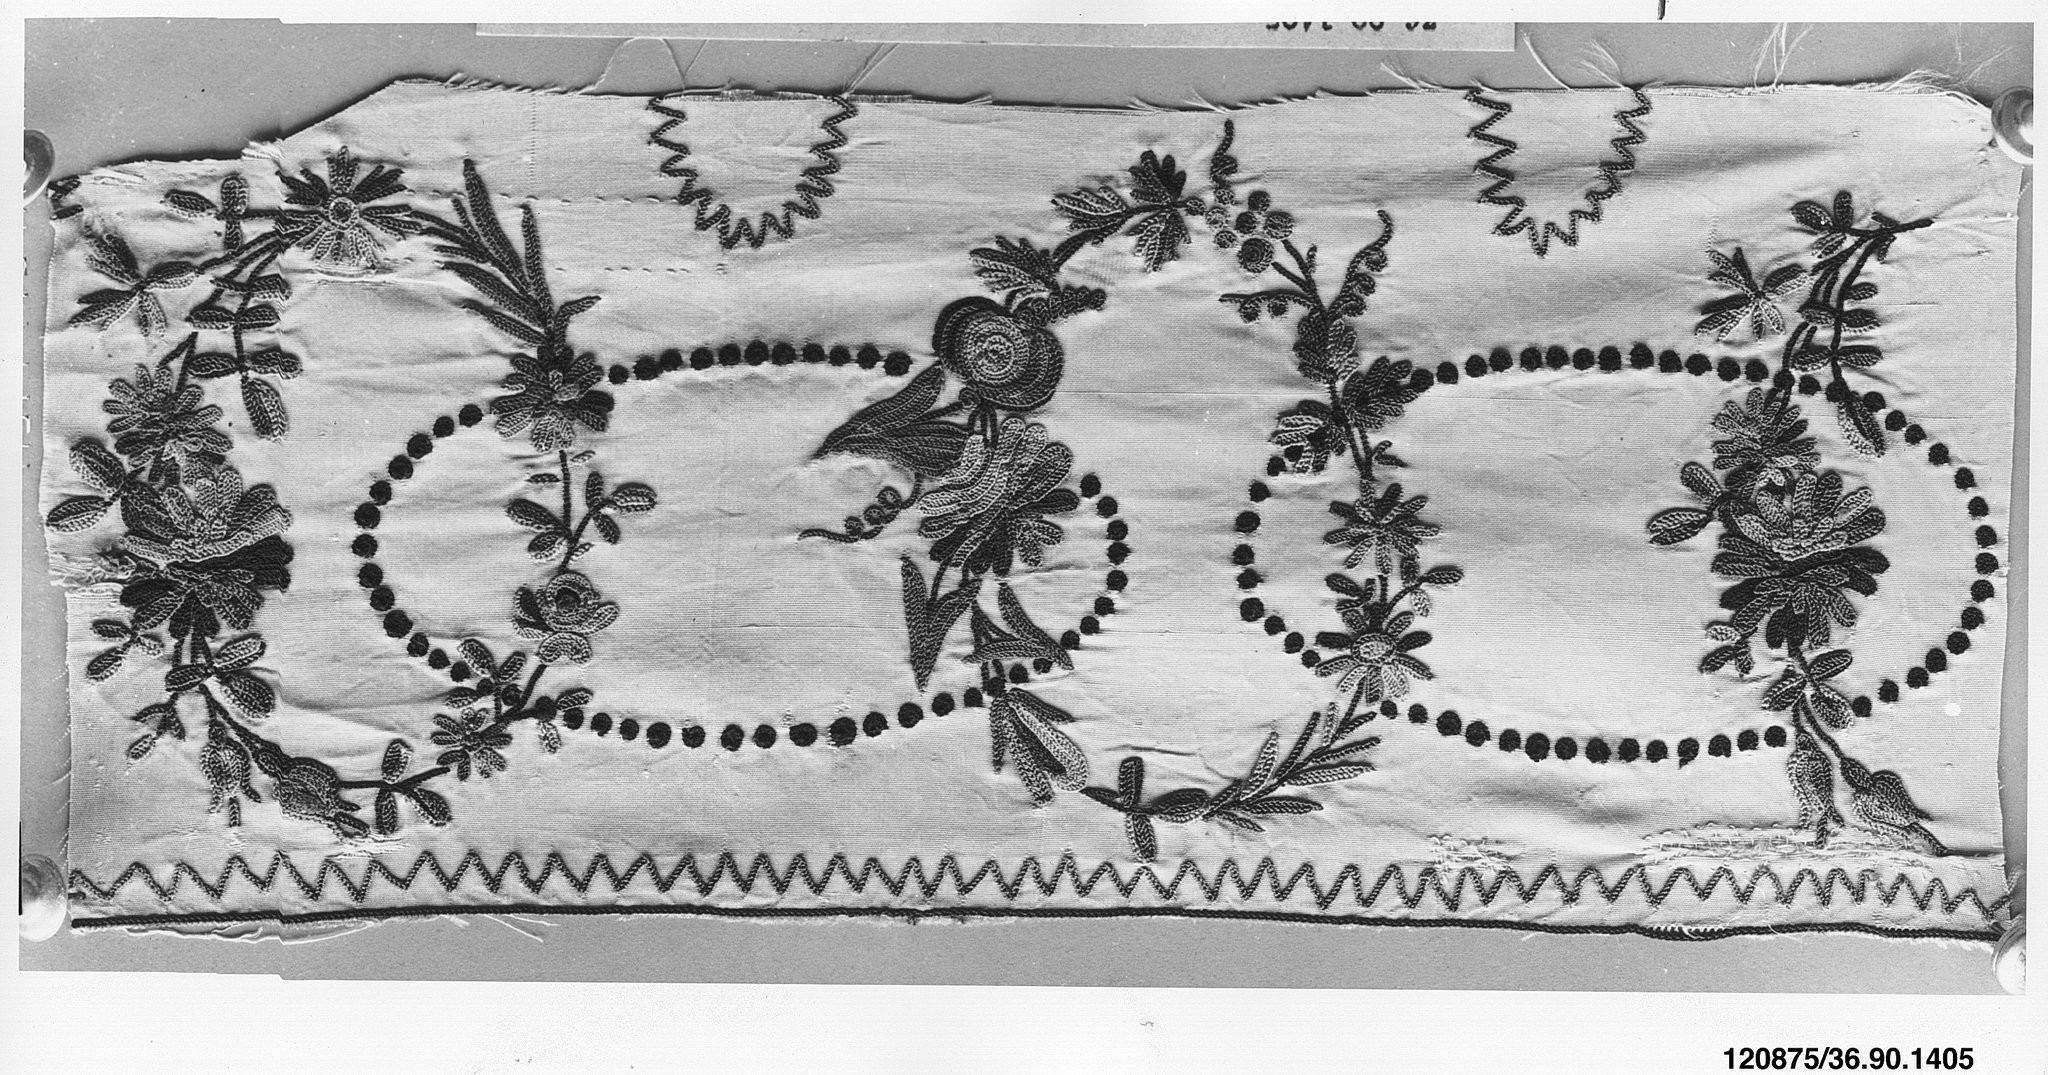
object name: piece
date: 1701-1800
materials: silk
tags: flowers